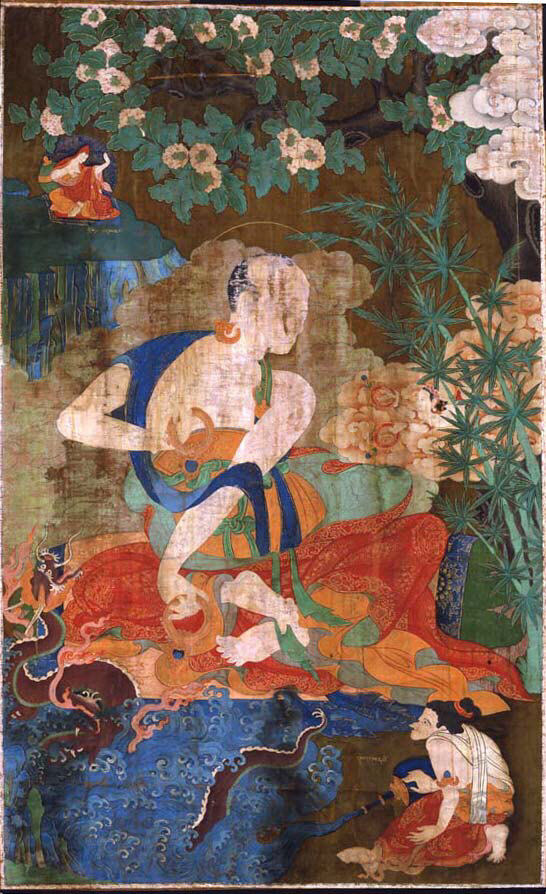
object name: thangka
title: Arhat Kalika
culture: tibetan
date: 1601-1700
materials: textile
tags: men,rivers,buddhism